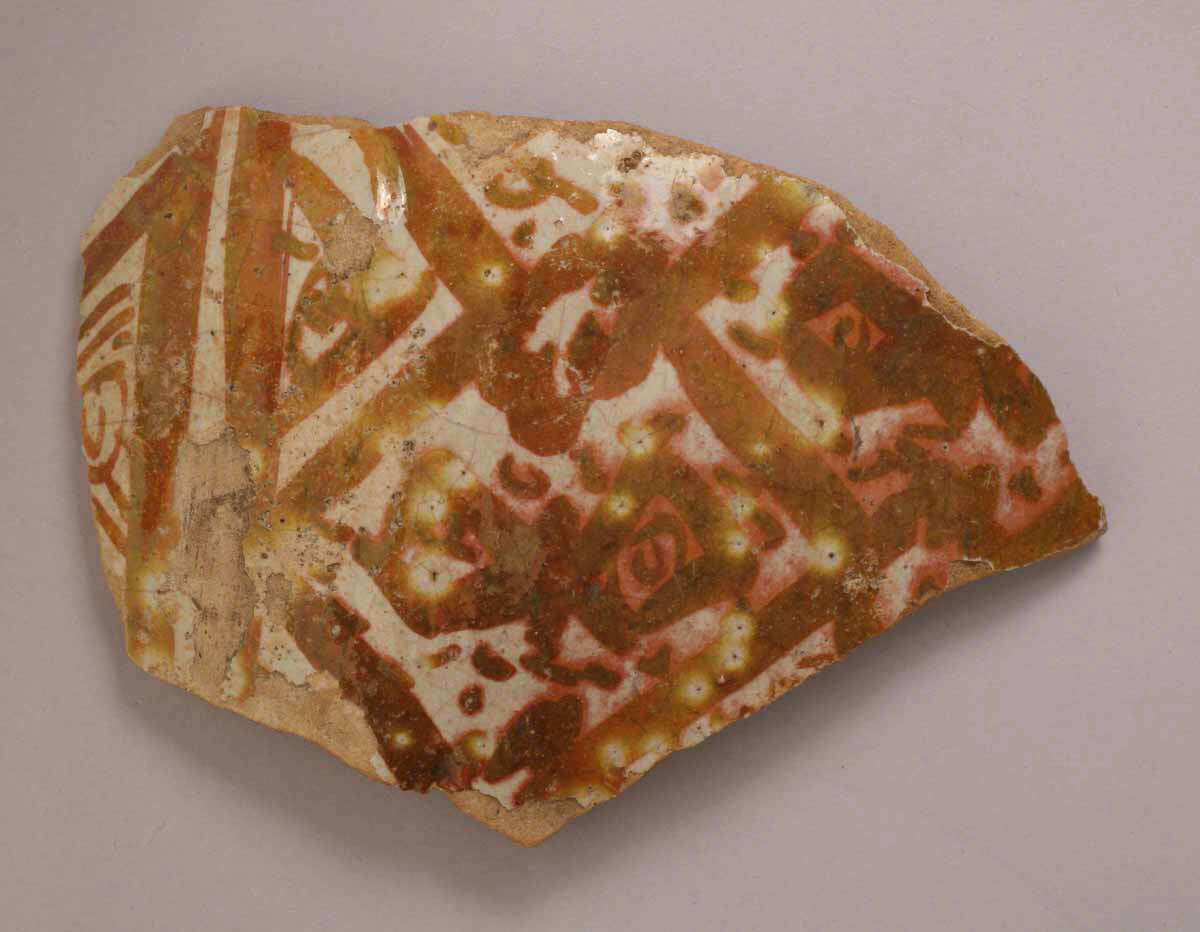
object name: ceramic fragment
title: Fragment of a Dish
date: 1001-1200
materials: earthenware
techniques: luster painting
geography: egypt